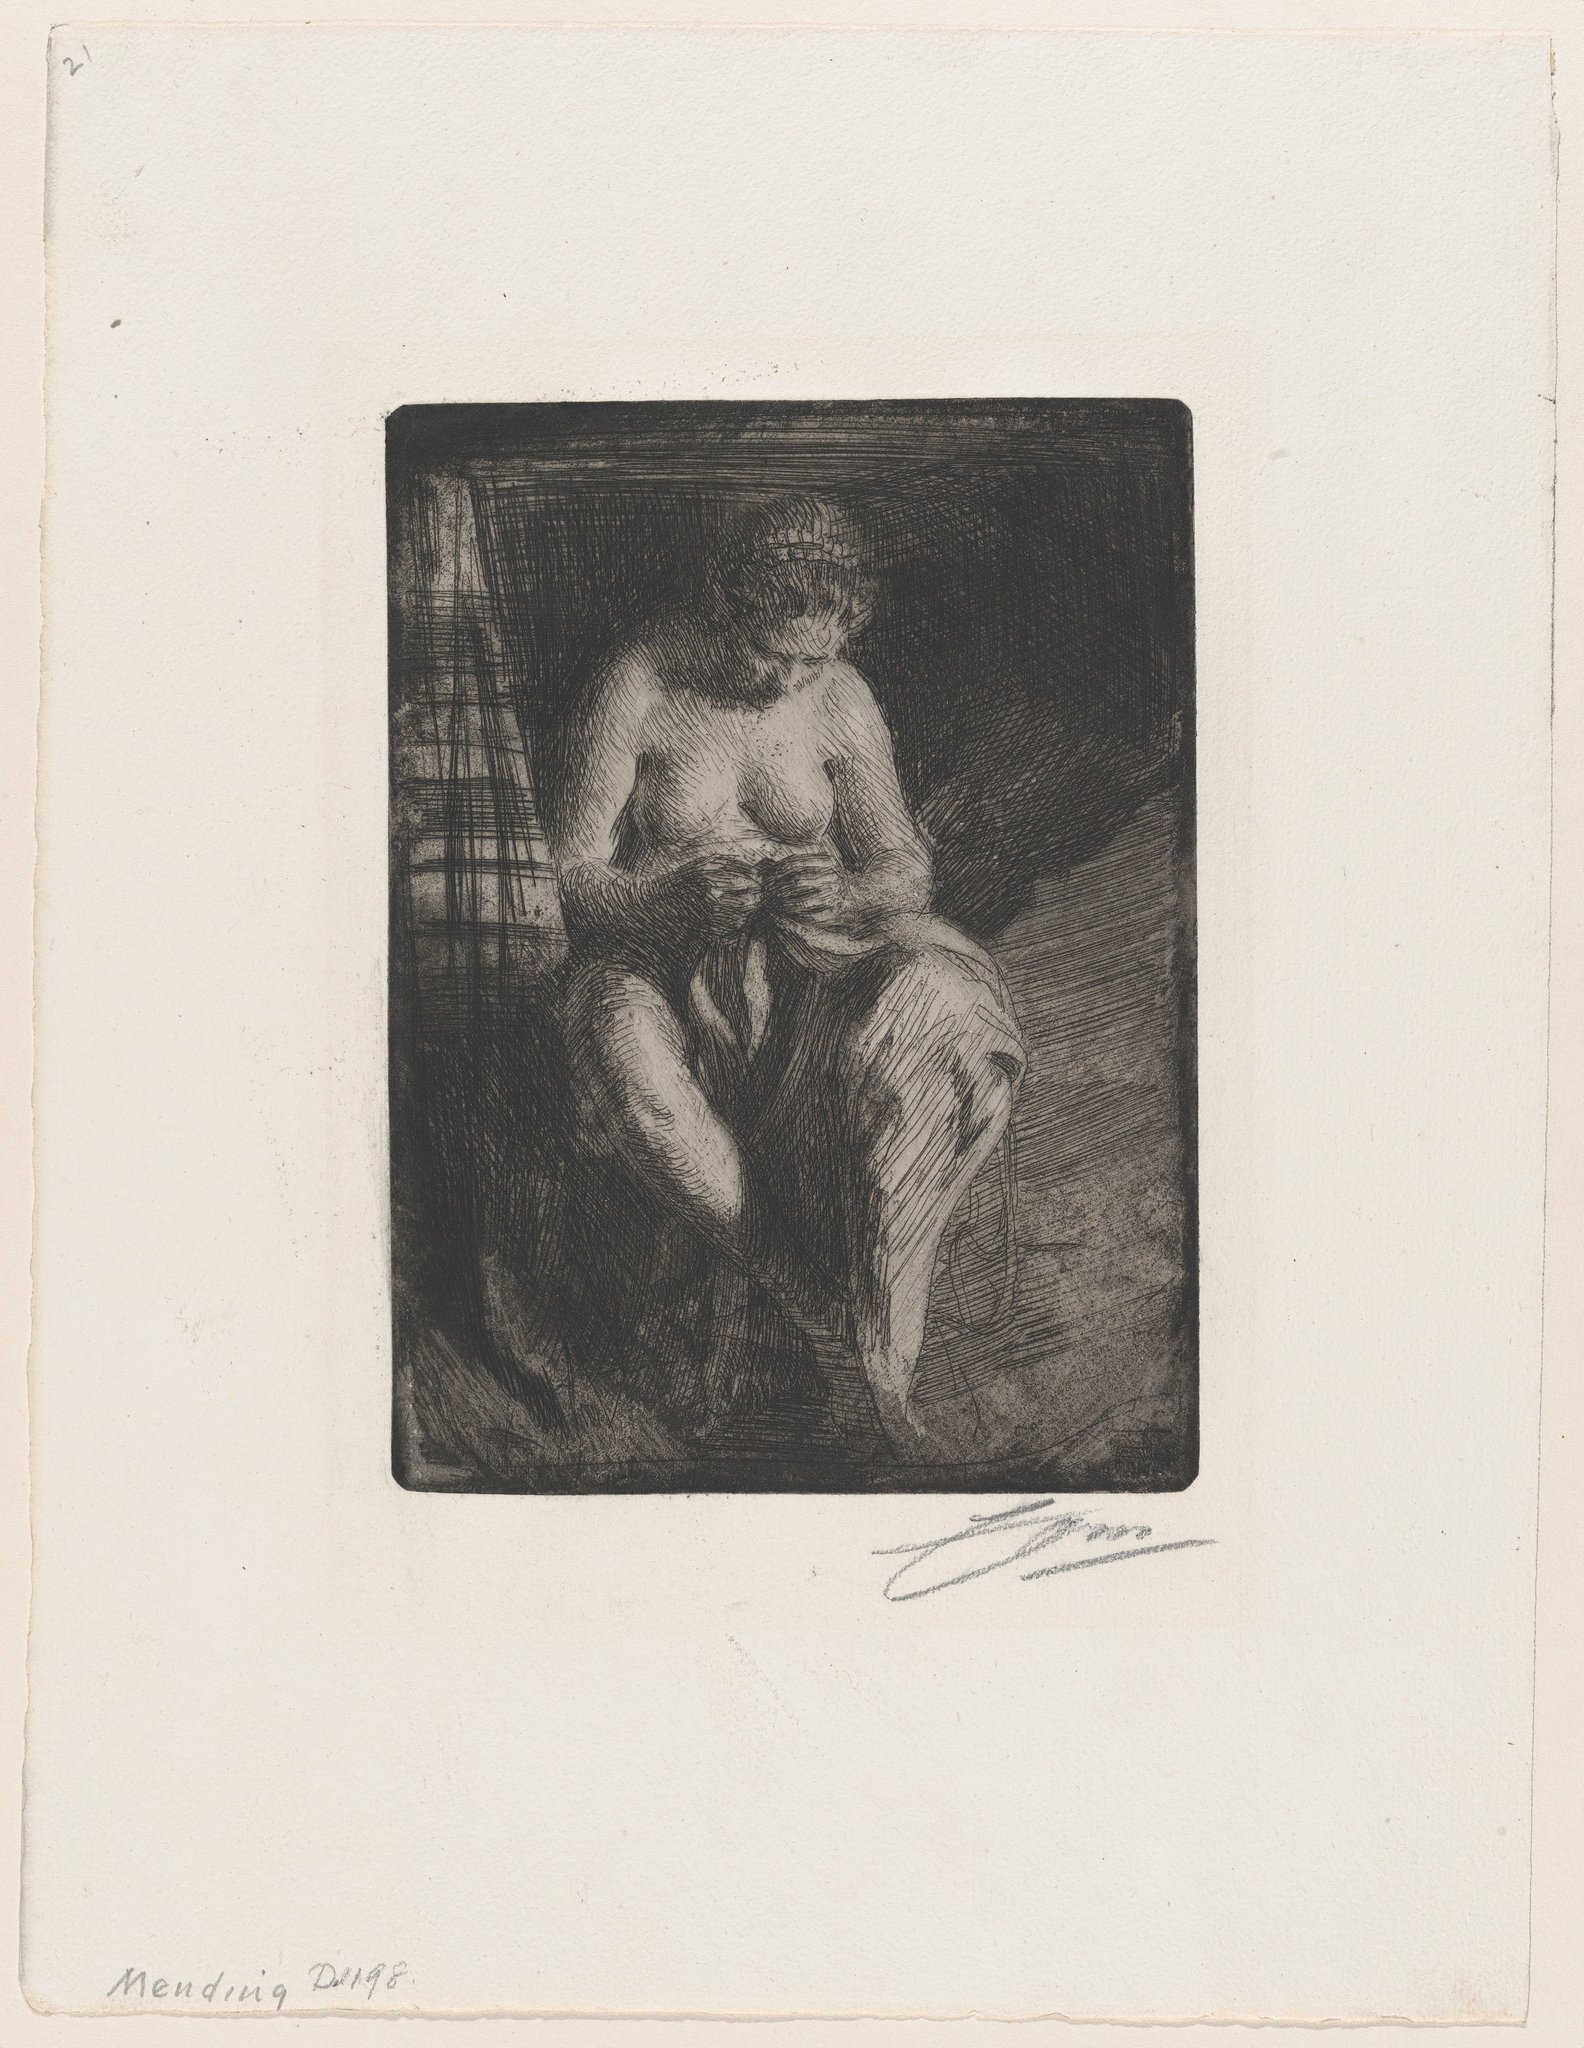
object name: print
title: Mending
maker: anders zorn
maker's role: artist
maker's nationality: swedish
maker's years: 1860-1920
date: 1905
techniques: etching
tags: female nudes